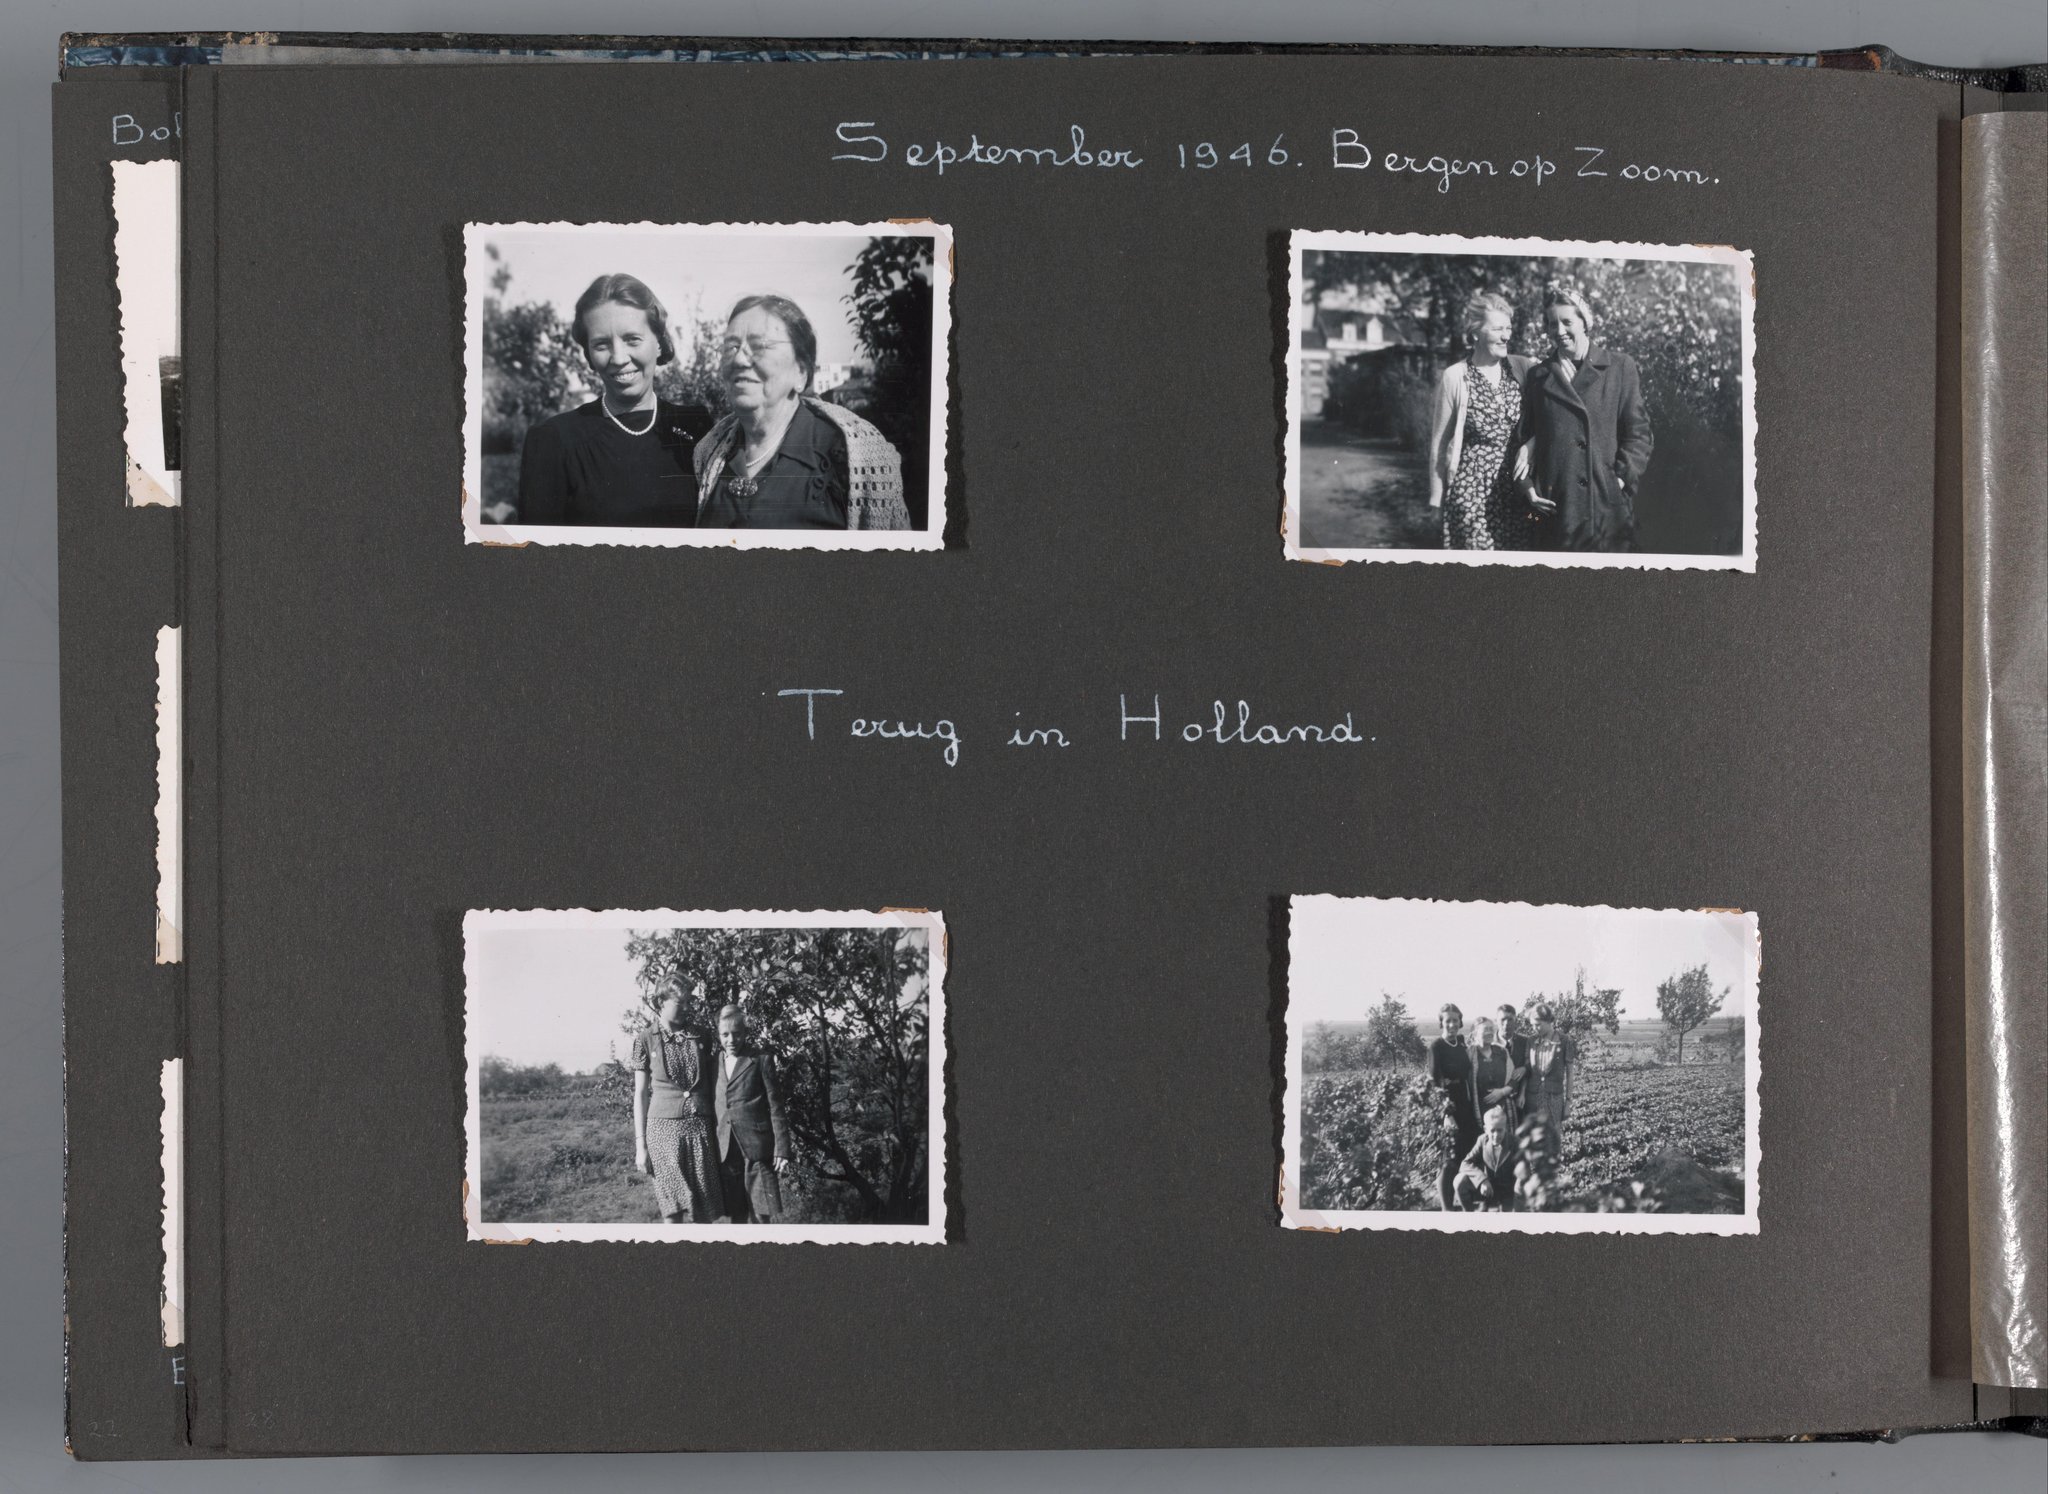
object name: photograph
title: Famile Vonk uit Nederlands-Indië gerepatrieerd terug in Nederland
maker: Anonymous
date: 1909-1946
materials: cardboard, photographic support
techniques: gelatin silver print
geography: bergen op zoom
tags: jet vonk, r.h. vonk, family group, especially parents with their child(ren), bergen op zoom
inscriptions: inscription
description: Albumblad met vier foto's van het gezin Vonk, na terugkeer in Nederland, herenigd met familie in Bergen op Zoom, in september 1946. Onderdeel van het familiealbum van Jet Vonk uit Celebes.